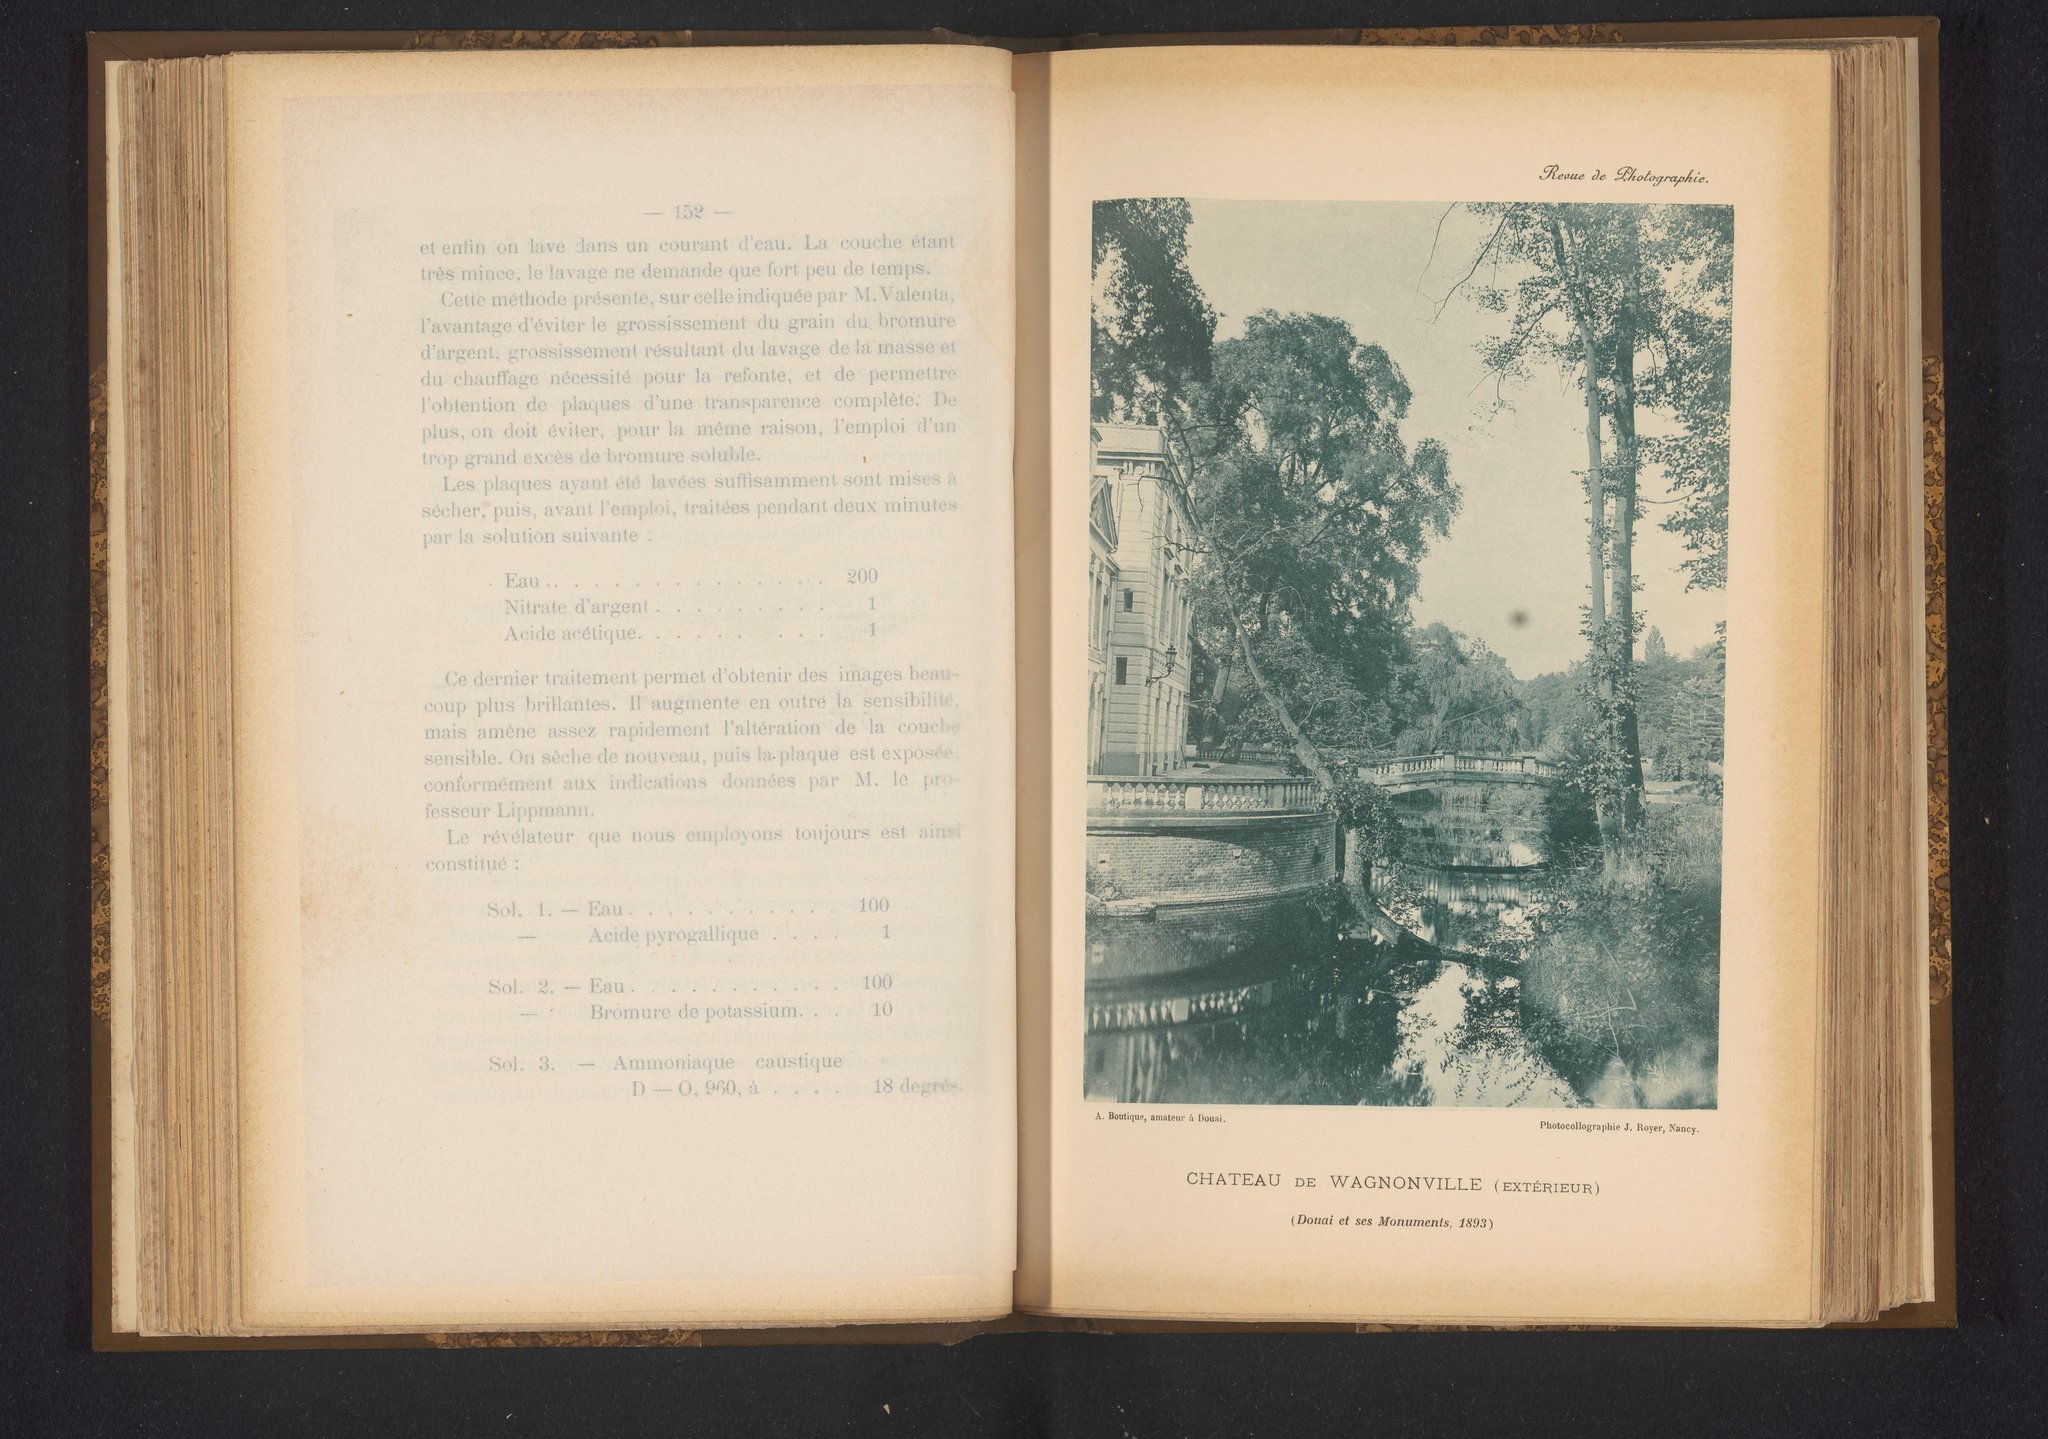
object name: photomechanical print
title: Gezicht op een landhuis aan het water te Wagonville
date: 1888-1893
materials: paper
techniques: photograph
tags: bridge, country-house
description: Prent op tweede en derde pagina na pagina 152.